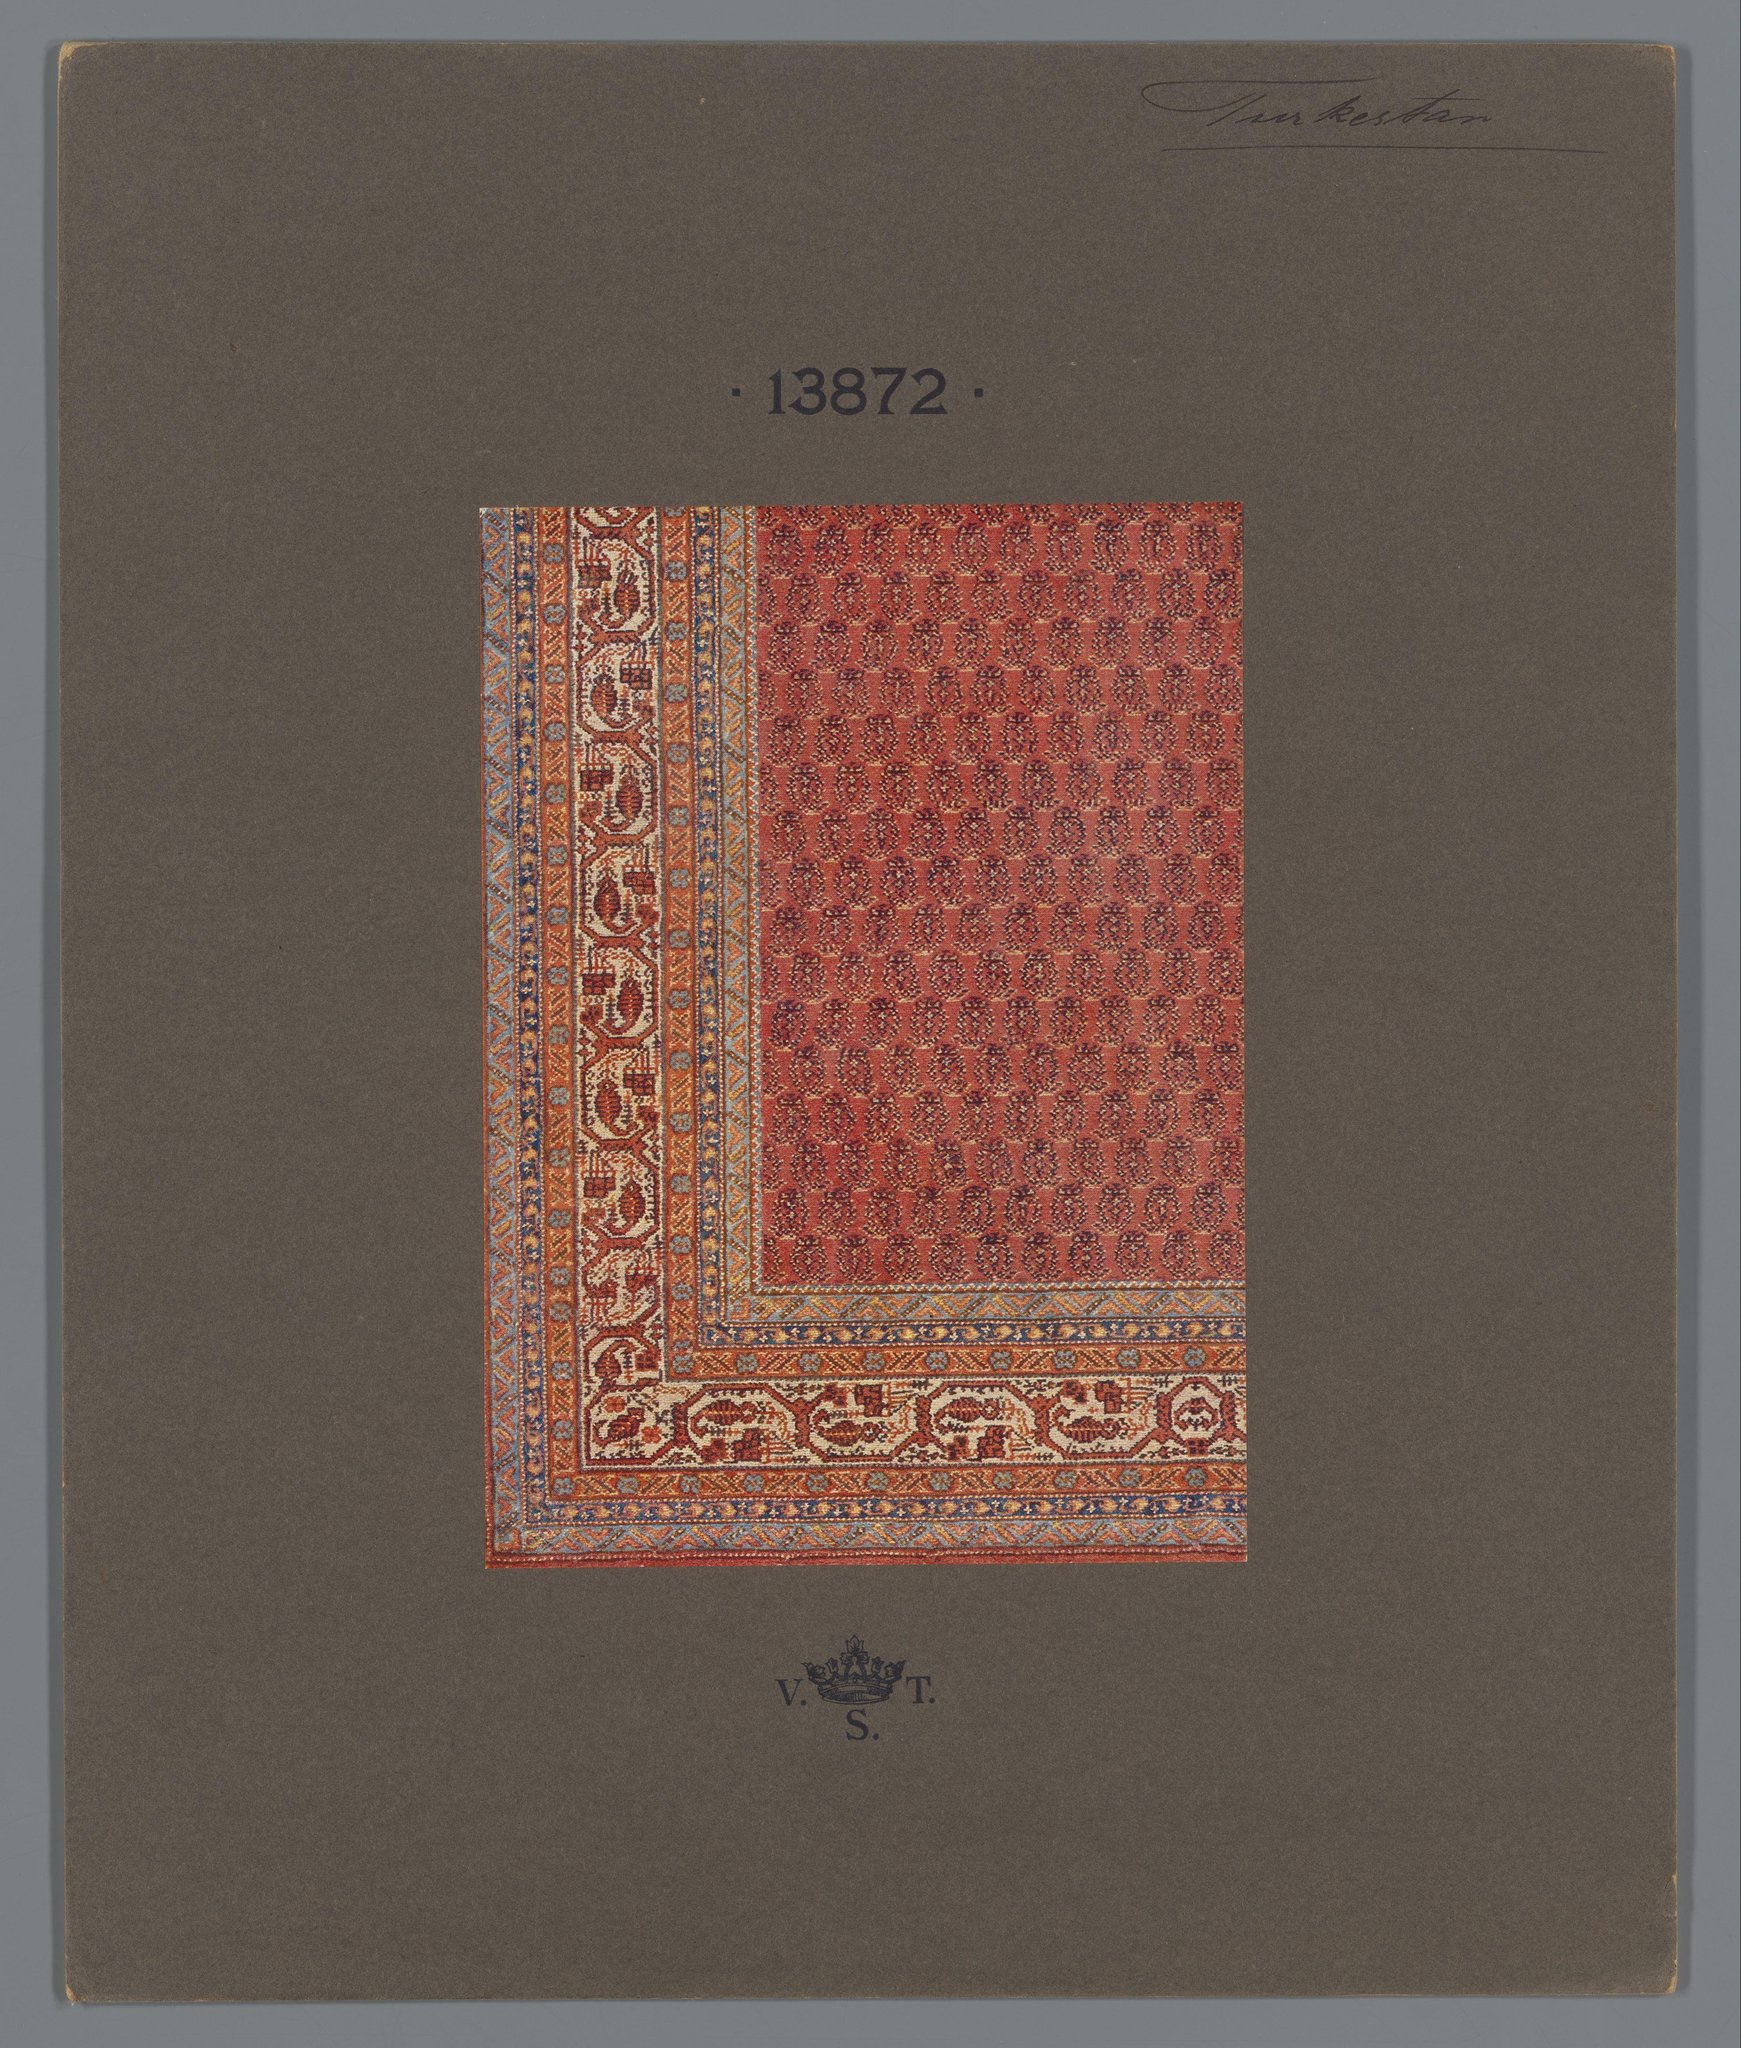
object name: photomechanical print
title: Deel van een tapijt met een patroon van fantasieornamenten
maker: Anonymous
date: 1907-1929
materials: cardboard, paper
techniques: autotype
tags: fantasy ornament, carpet, rug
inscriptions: number: ‘.13872.’, number: ‘124/ 12’, mark: ‘V.T.S.’, annotation: ‘Turkestan’